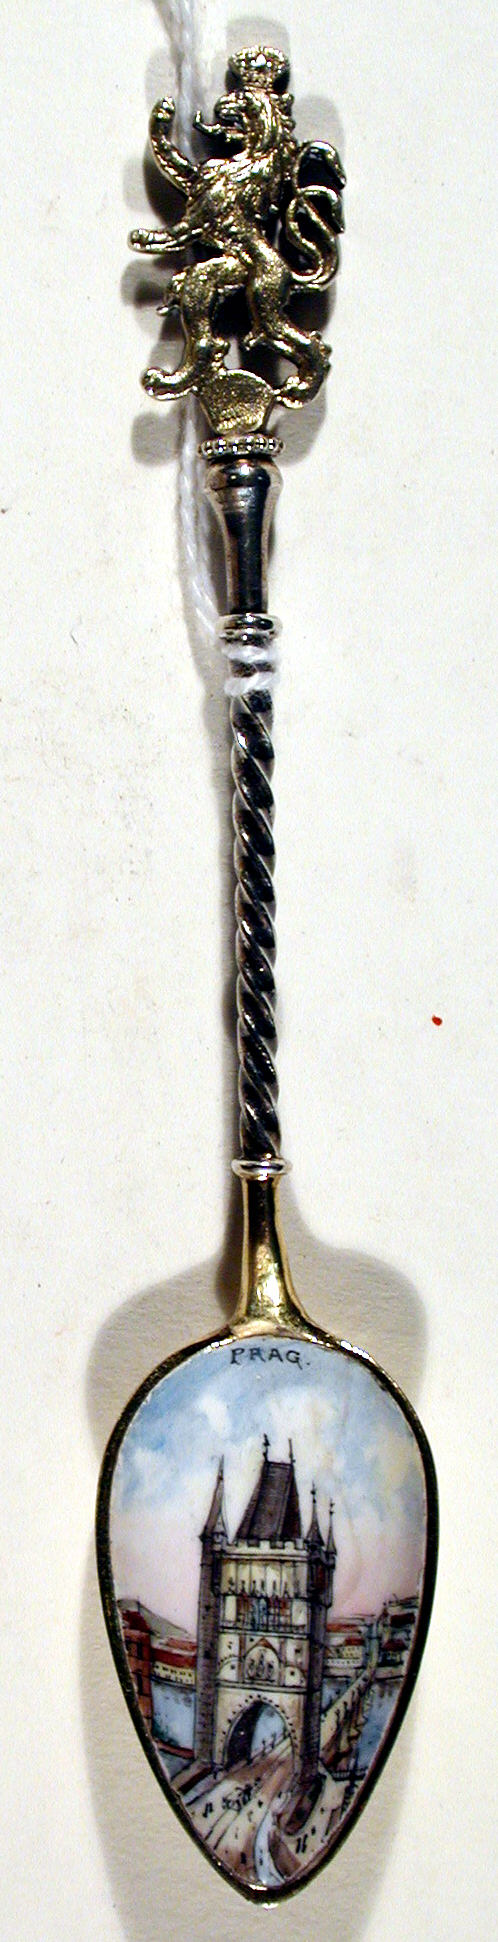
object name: souvenir spoon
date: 1867-1900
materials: enamel, gilt, silver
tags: bridges,lions